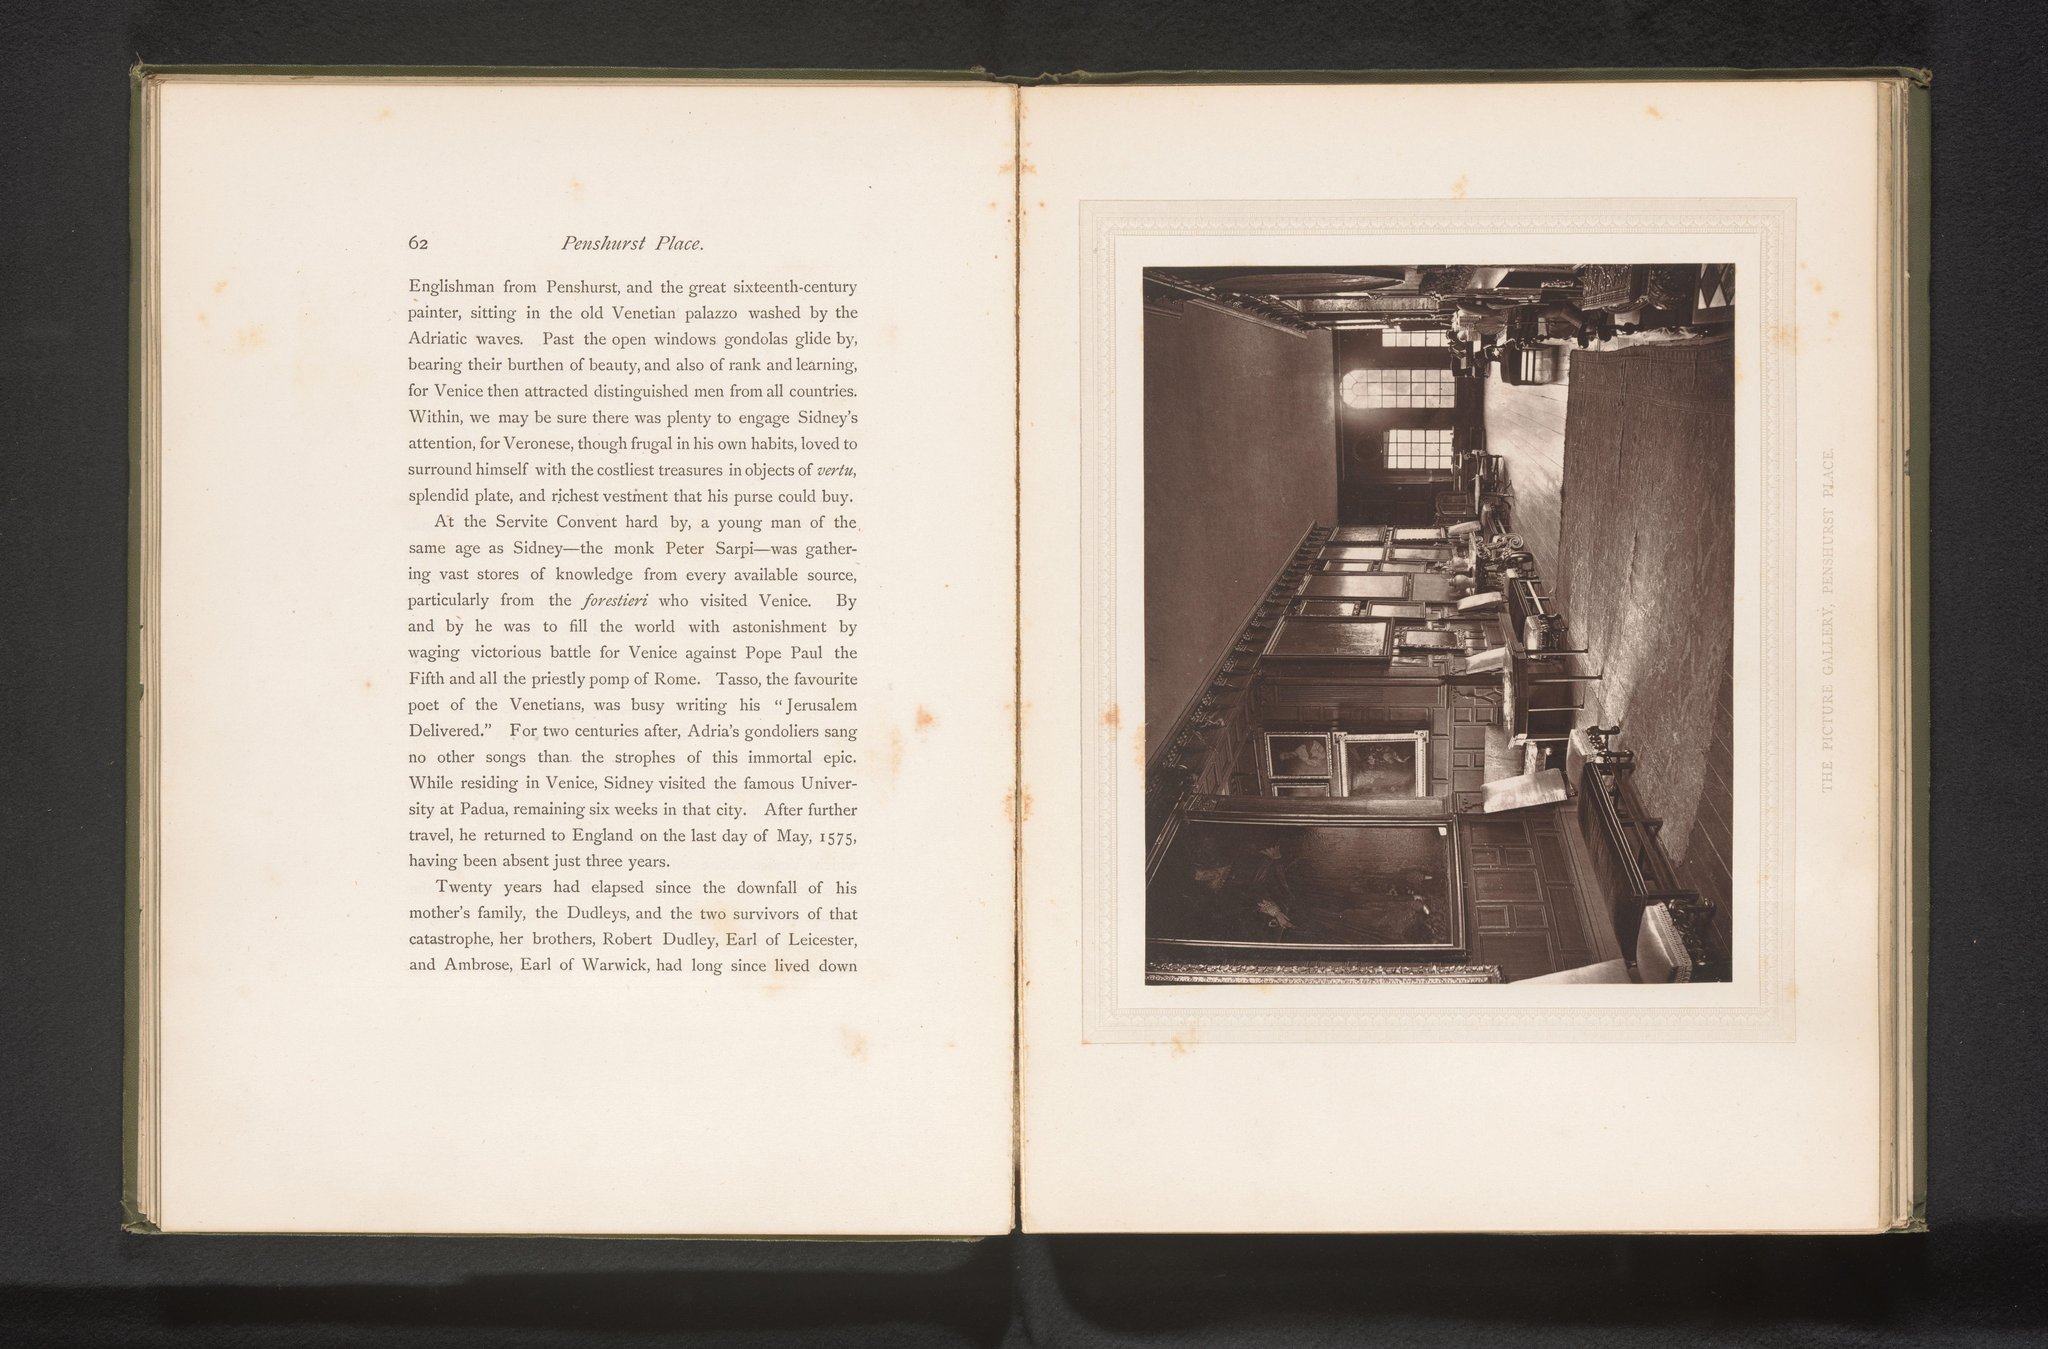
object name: photomechanical print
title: Interieur van een schilderijenzaal in Penshurst Place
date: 1866-1876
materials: paper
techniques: woodburytype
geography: penshurst place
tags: art collection, art gallery, interior of the house